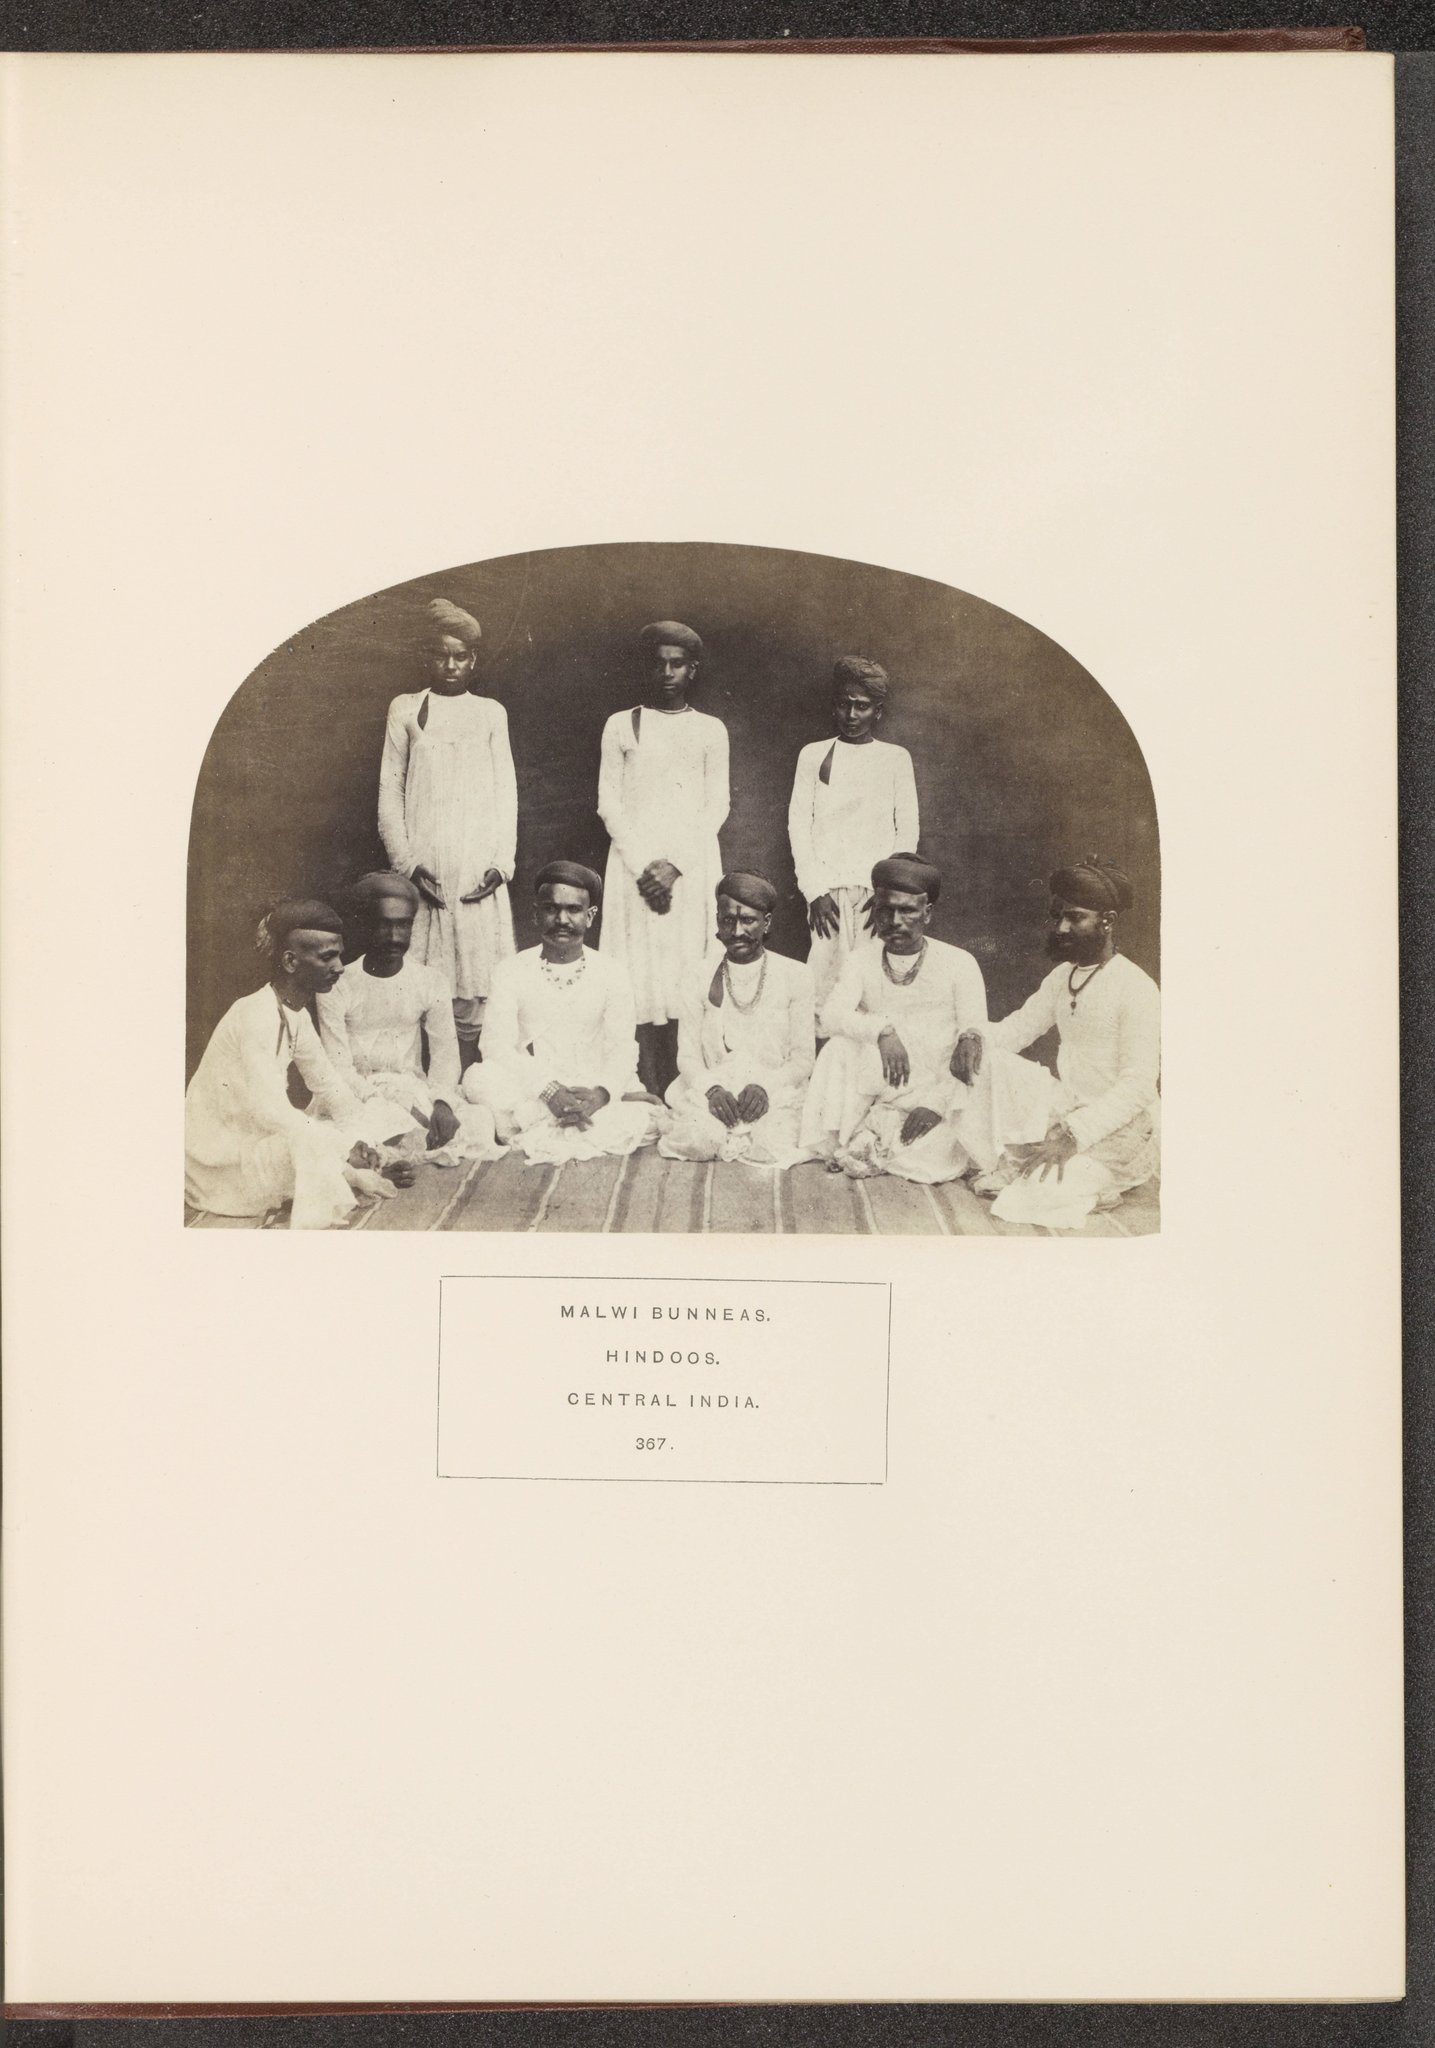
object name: page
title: Portrait of nine unknown men from Marwar, Rajasthan, who came to central India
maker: james john waterhouse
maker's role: fotograaf, luitenant, officier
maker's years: 1842-1928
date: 1862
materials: photographic support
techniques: albumen print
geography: madhya pradesh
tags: human races; peoples; nationalities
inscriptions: inscription: ‘MALWI BUNNEAS./ HINDOOS./ CENTRAL INDIA.’, number: ‘367.’